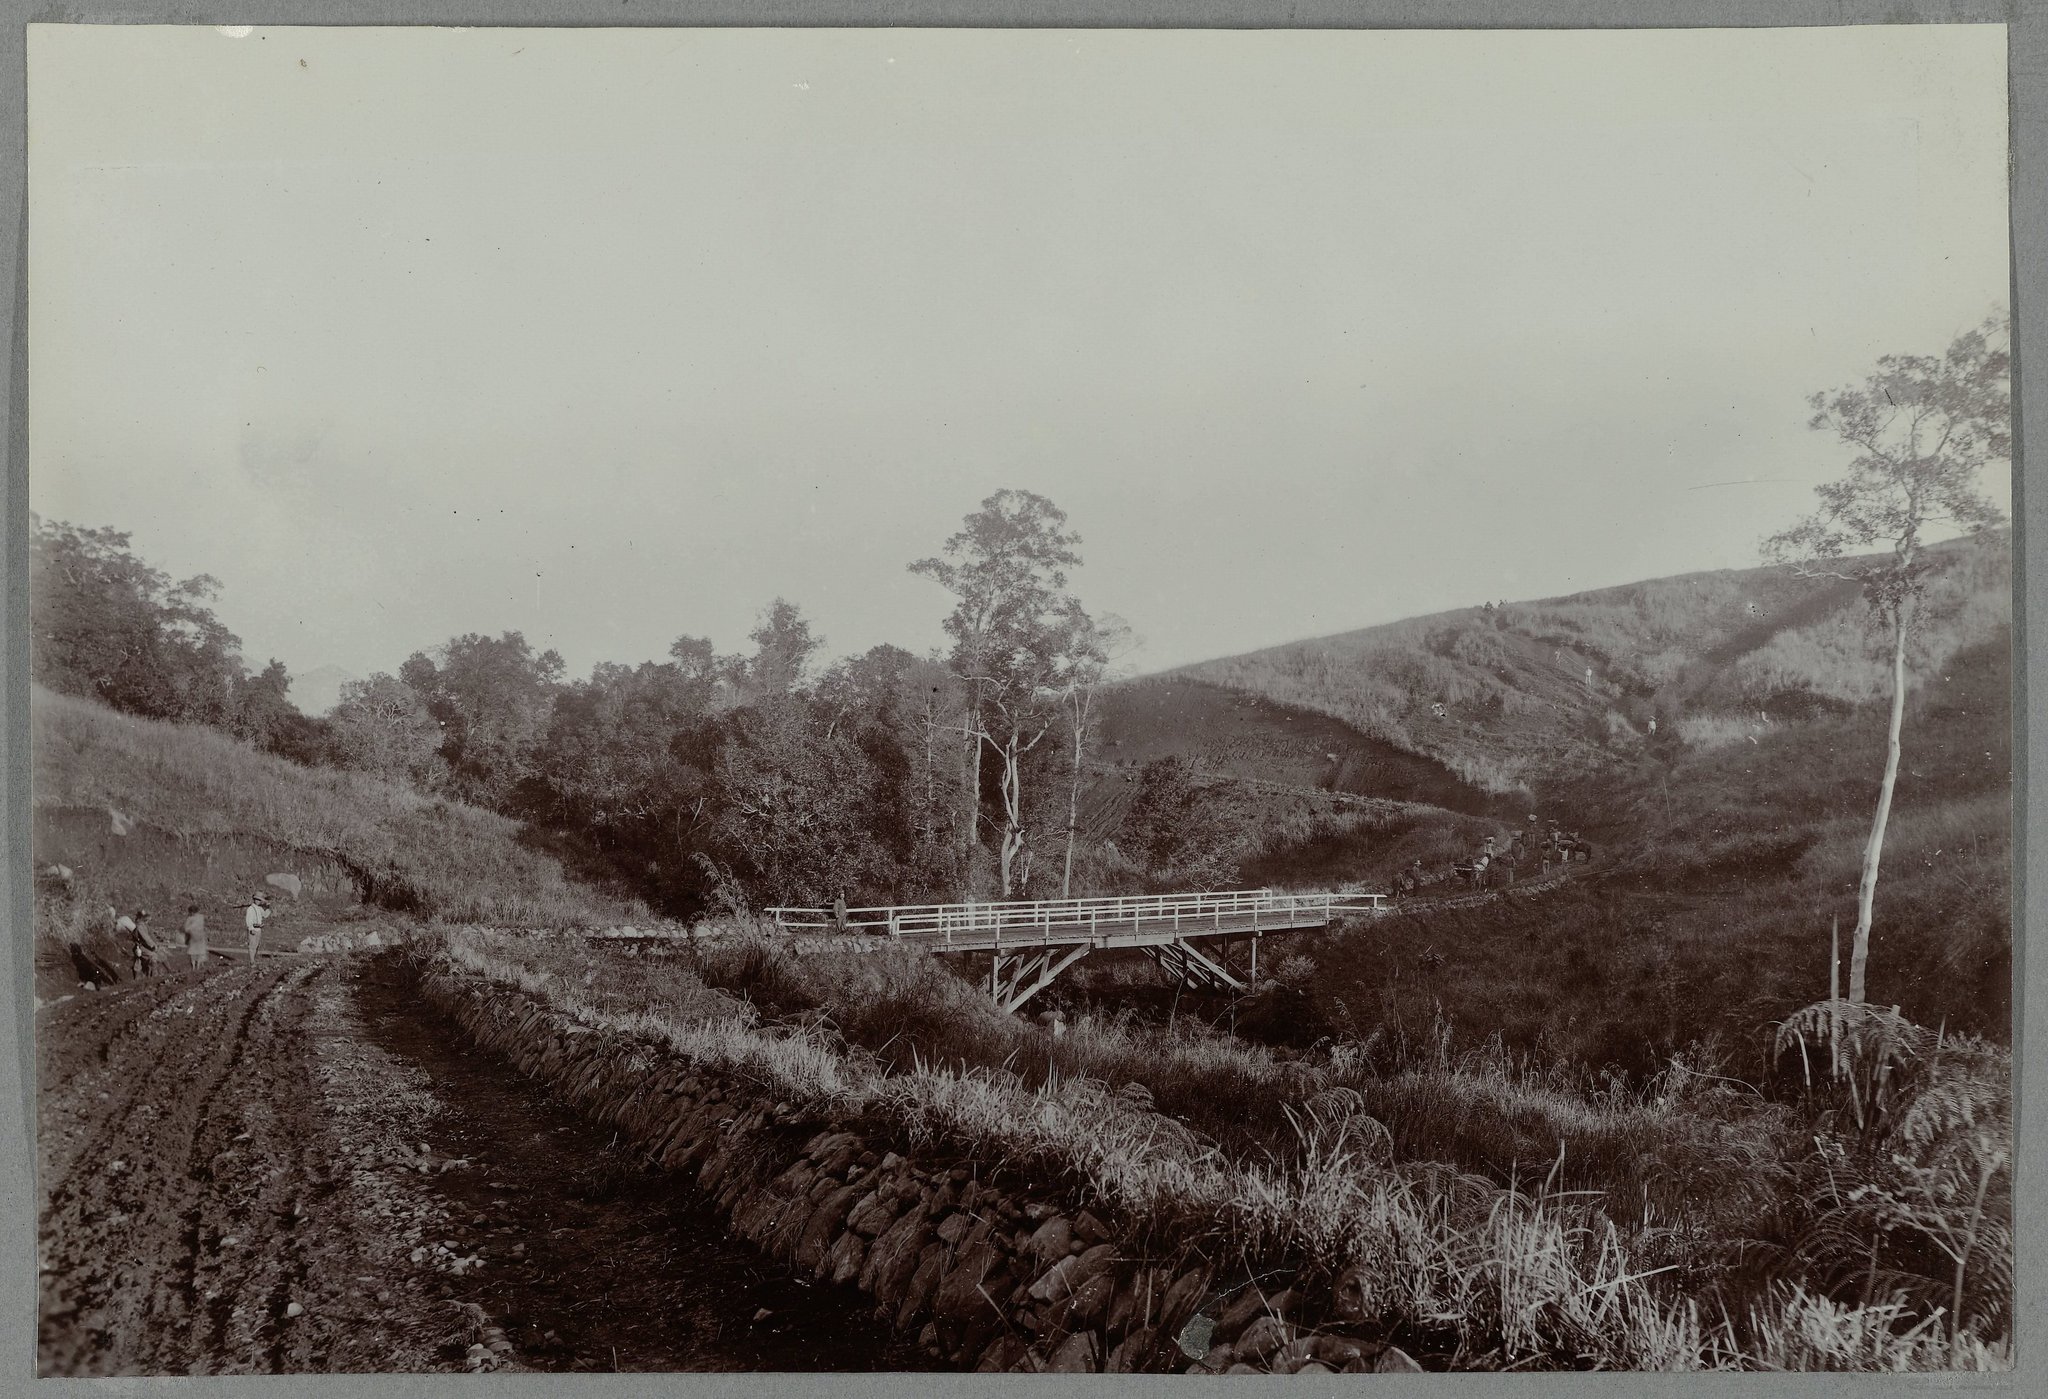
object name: photograph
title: Brug over de Woih ni Koelos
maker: Anonymous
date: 1903-1913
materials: photographic support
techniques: photography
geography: north sumatra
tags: arnhem, the hague, albertus dominicus laman trip, building activities, traffic by road or path with motor-vehicle, landscapes in tropical and sub-tropical regions, road, path, bridge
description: Na de expedities naar de Gajo- en Alaslanden o.l.v. Van Daalen (eerste tocht in 1901), werd hij in 1903 belast met voorbereiding van permanente vestiging van Nederlands gezag. Aanleg van een weg van de Noordkust naar het binnenland was hierbij van groot belang. Deze zgn. Gajoweg werd aangelegd tussen 1903 en 1914, van Bireuen aan de kust naar Takinguen aan het bergmeer Danau Lauttawar, totale lente 104 km.